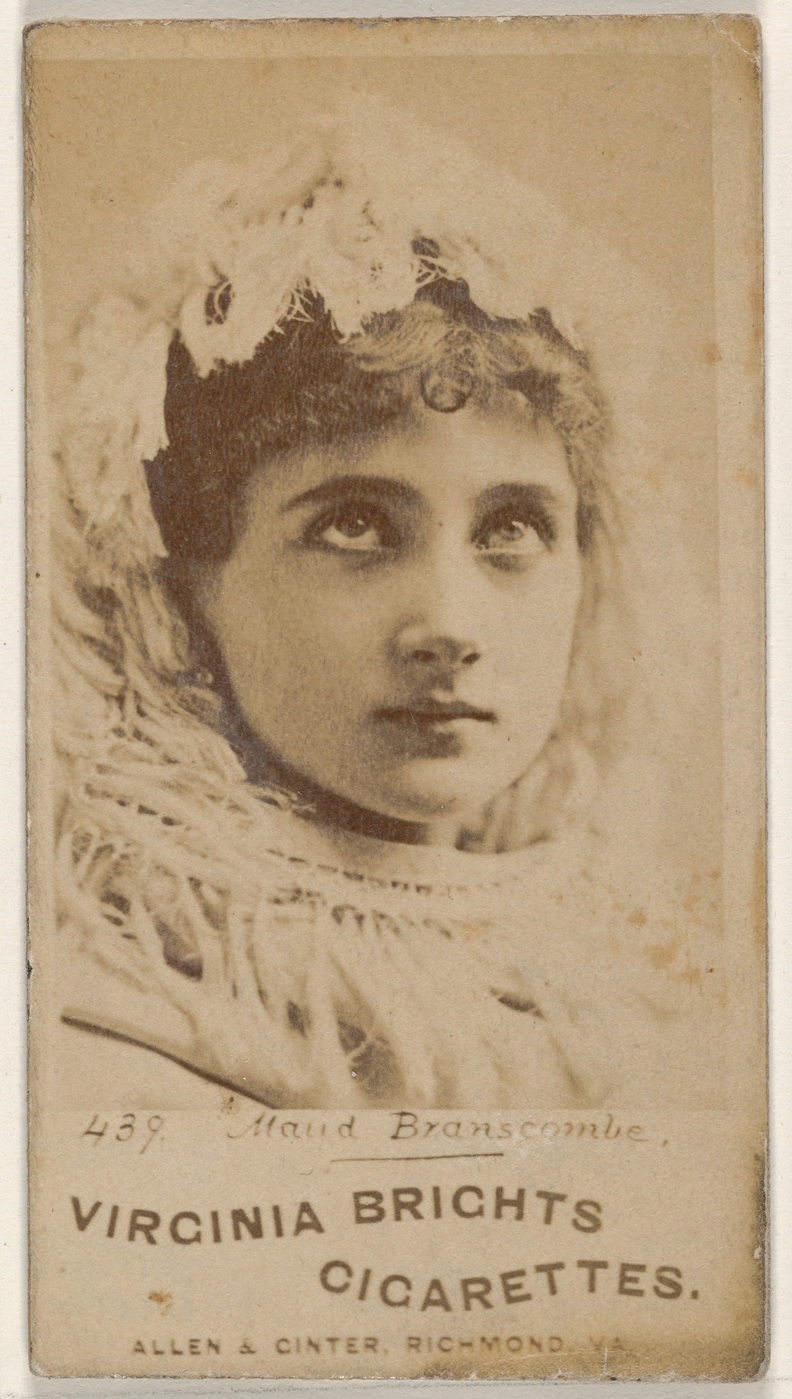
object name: photograph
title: Card 439, Maud Branscombe, from the Actors and Actresses series (N45, Type 1) for Virginia Brights Cigarettes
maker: allen & ginter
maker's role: publisher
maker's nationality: american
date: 1888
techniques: albumen silver print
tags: portraits,women,actresses